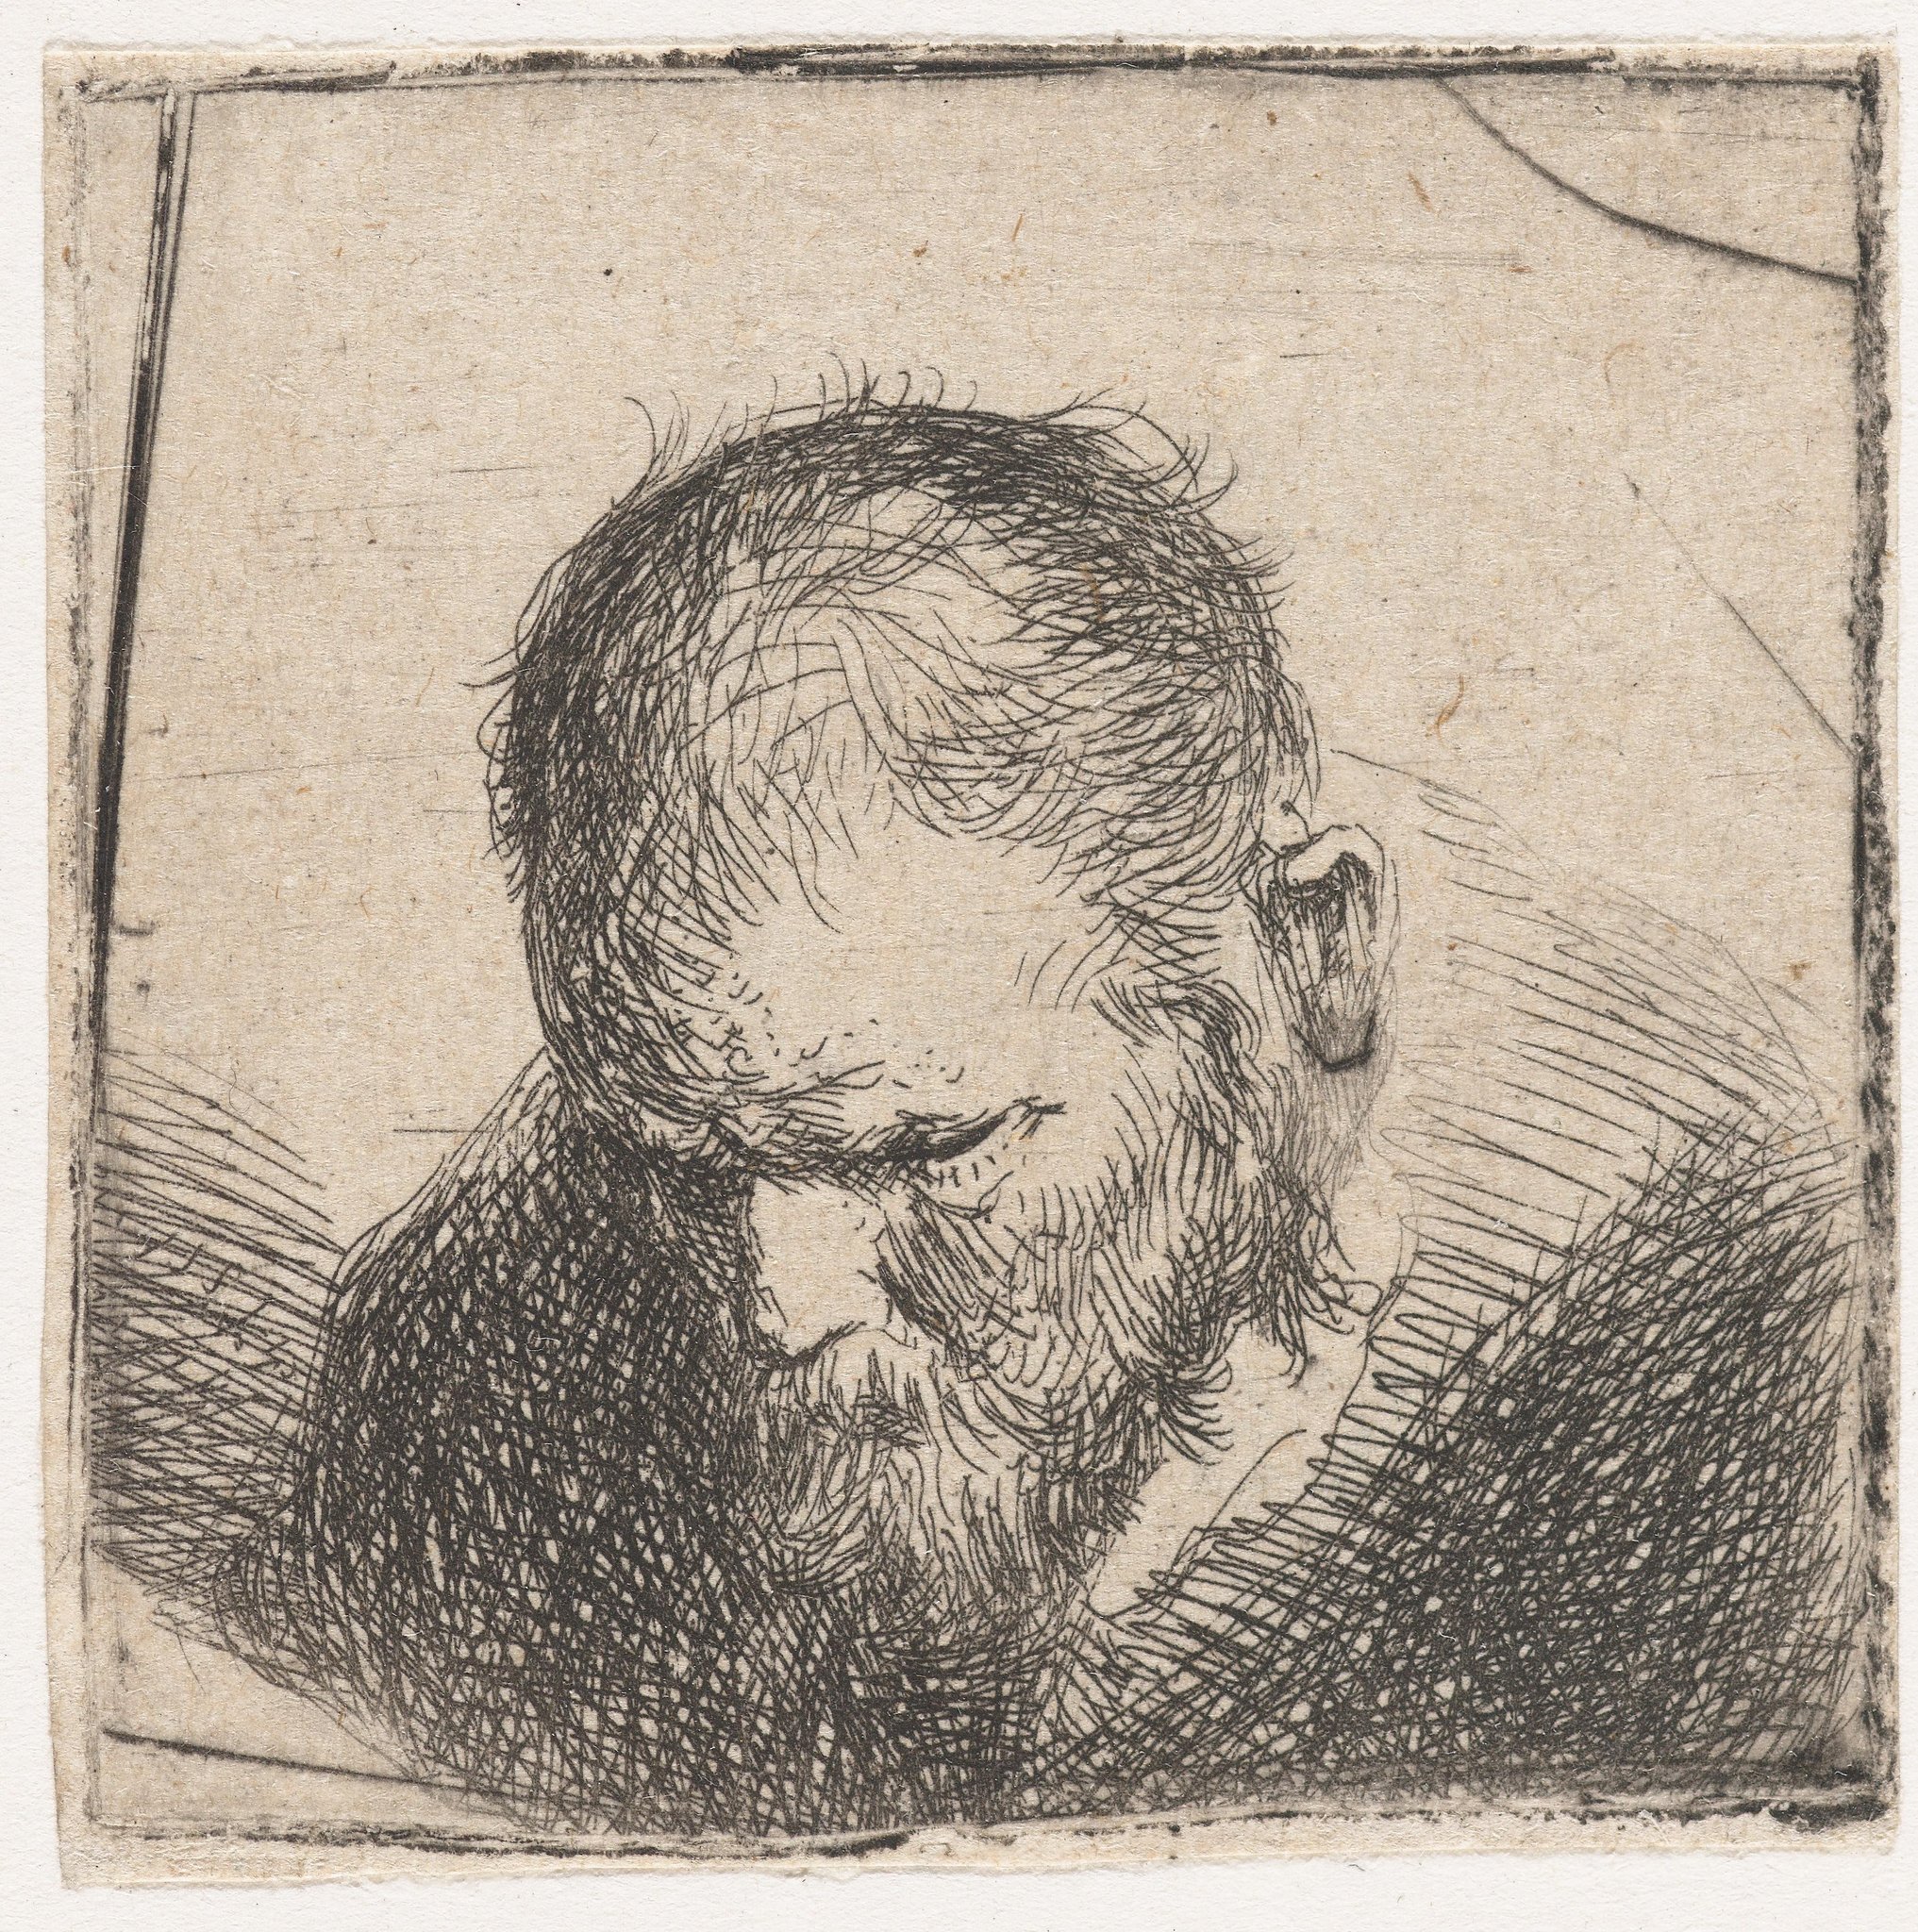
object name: print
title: Man met baard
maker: jan lievens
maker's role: draughtsman, painter, print maker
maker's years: 1607-1674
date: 1620-1700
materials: paper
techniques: drypoint, etching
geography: netherlands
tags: morphology of human expression (+ downward)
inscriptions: collector's mark: Lugt 2165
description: Man met een baard, kijkend naar beneden.